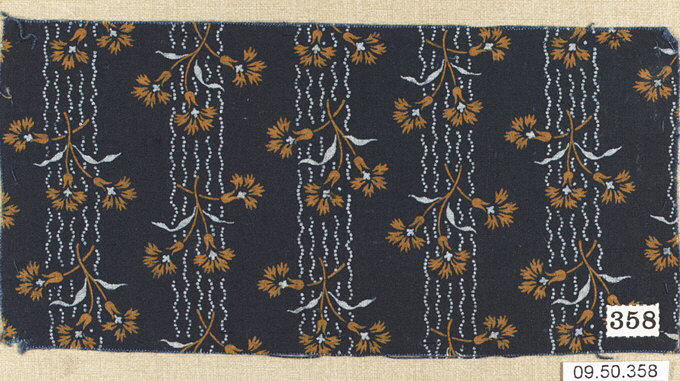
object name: piece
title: Piece (one of 116)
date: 1801-1900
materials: cotton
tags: flowers,leaves